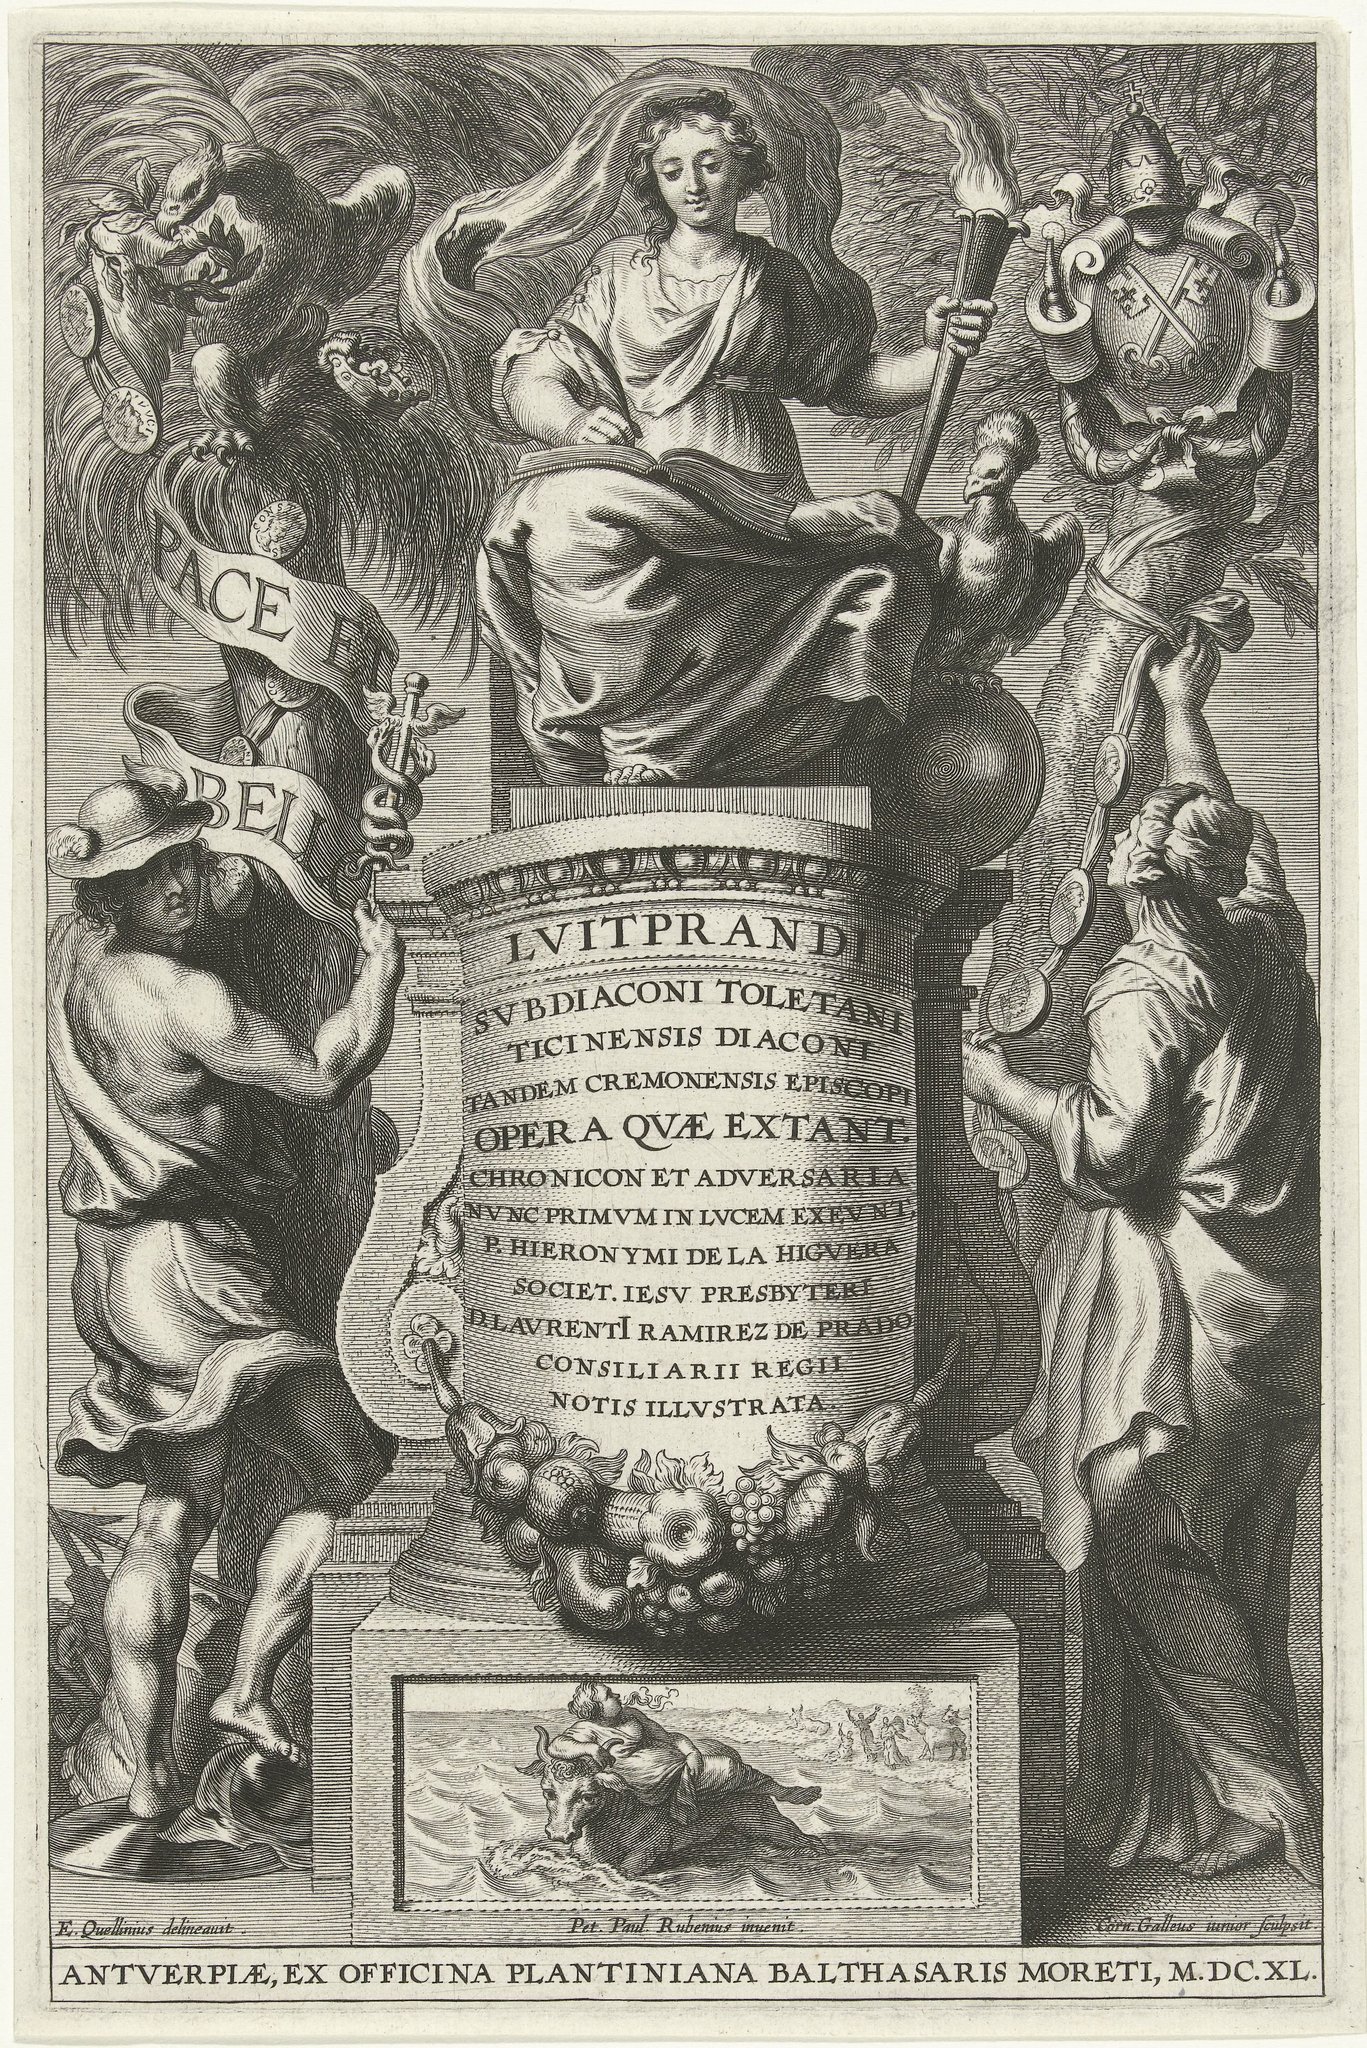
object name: print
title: Geschiedenis zittend op een troon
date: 1640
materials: paper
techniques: engraving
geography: antwerp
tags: jupiter, usually in the shape of a white bull, abducts europa and carries her across the water, (story of) mercury (hermes), 'historia'; 'historia' (ripa)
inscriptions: collector's mark: Lugt 240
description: De vrouwelijke personificatie van geschiedenis zit op een stenen troon en schrijft met een veer in een boek. Aan weerszijden van de troon staan Mercurius en een vrouw die guirlandes met medailles aan een palm en een loofboom hangen. Op de sokkel van de troon een verwijzing naar de roof van Europa.